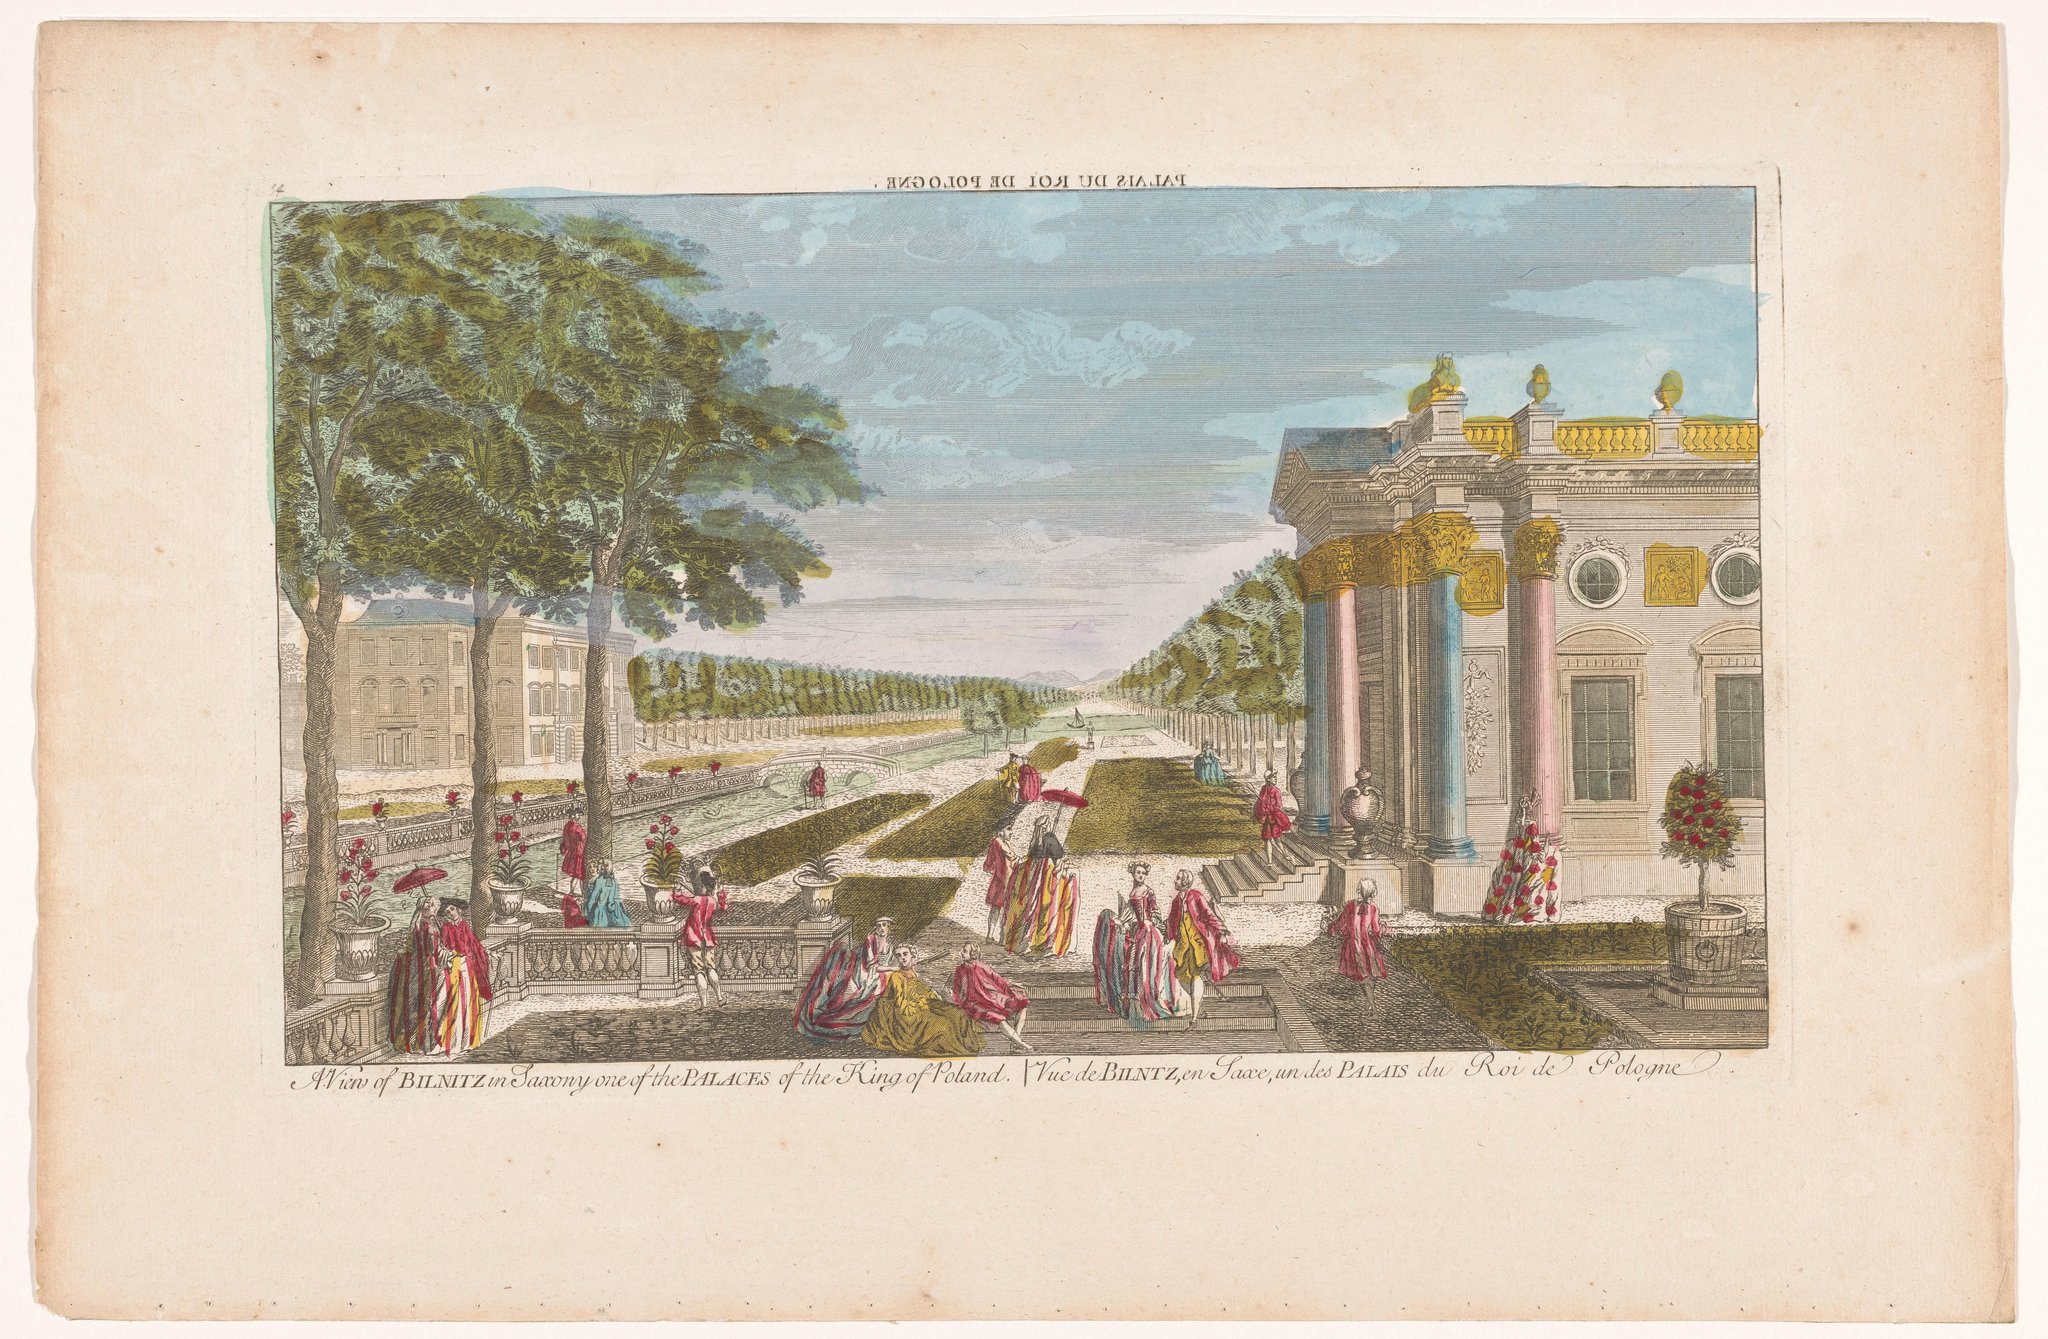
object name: print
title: A view of Bilnitz in Saxony one of the palaces of the king of Poland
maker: Anonymous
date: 1752-1799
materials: paper, watercolor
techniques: brush, etching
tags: garden, civic architecture; edifices; dwellings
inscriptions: watermark:, collector's mark: Lugt 2166